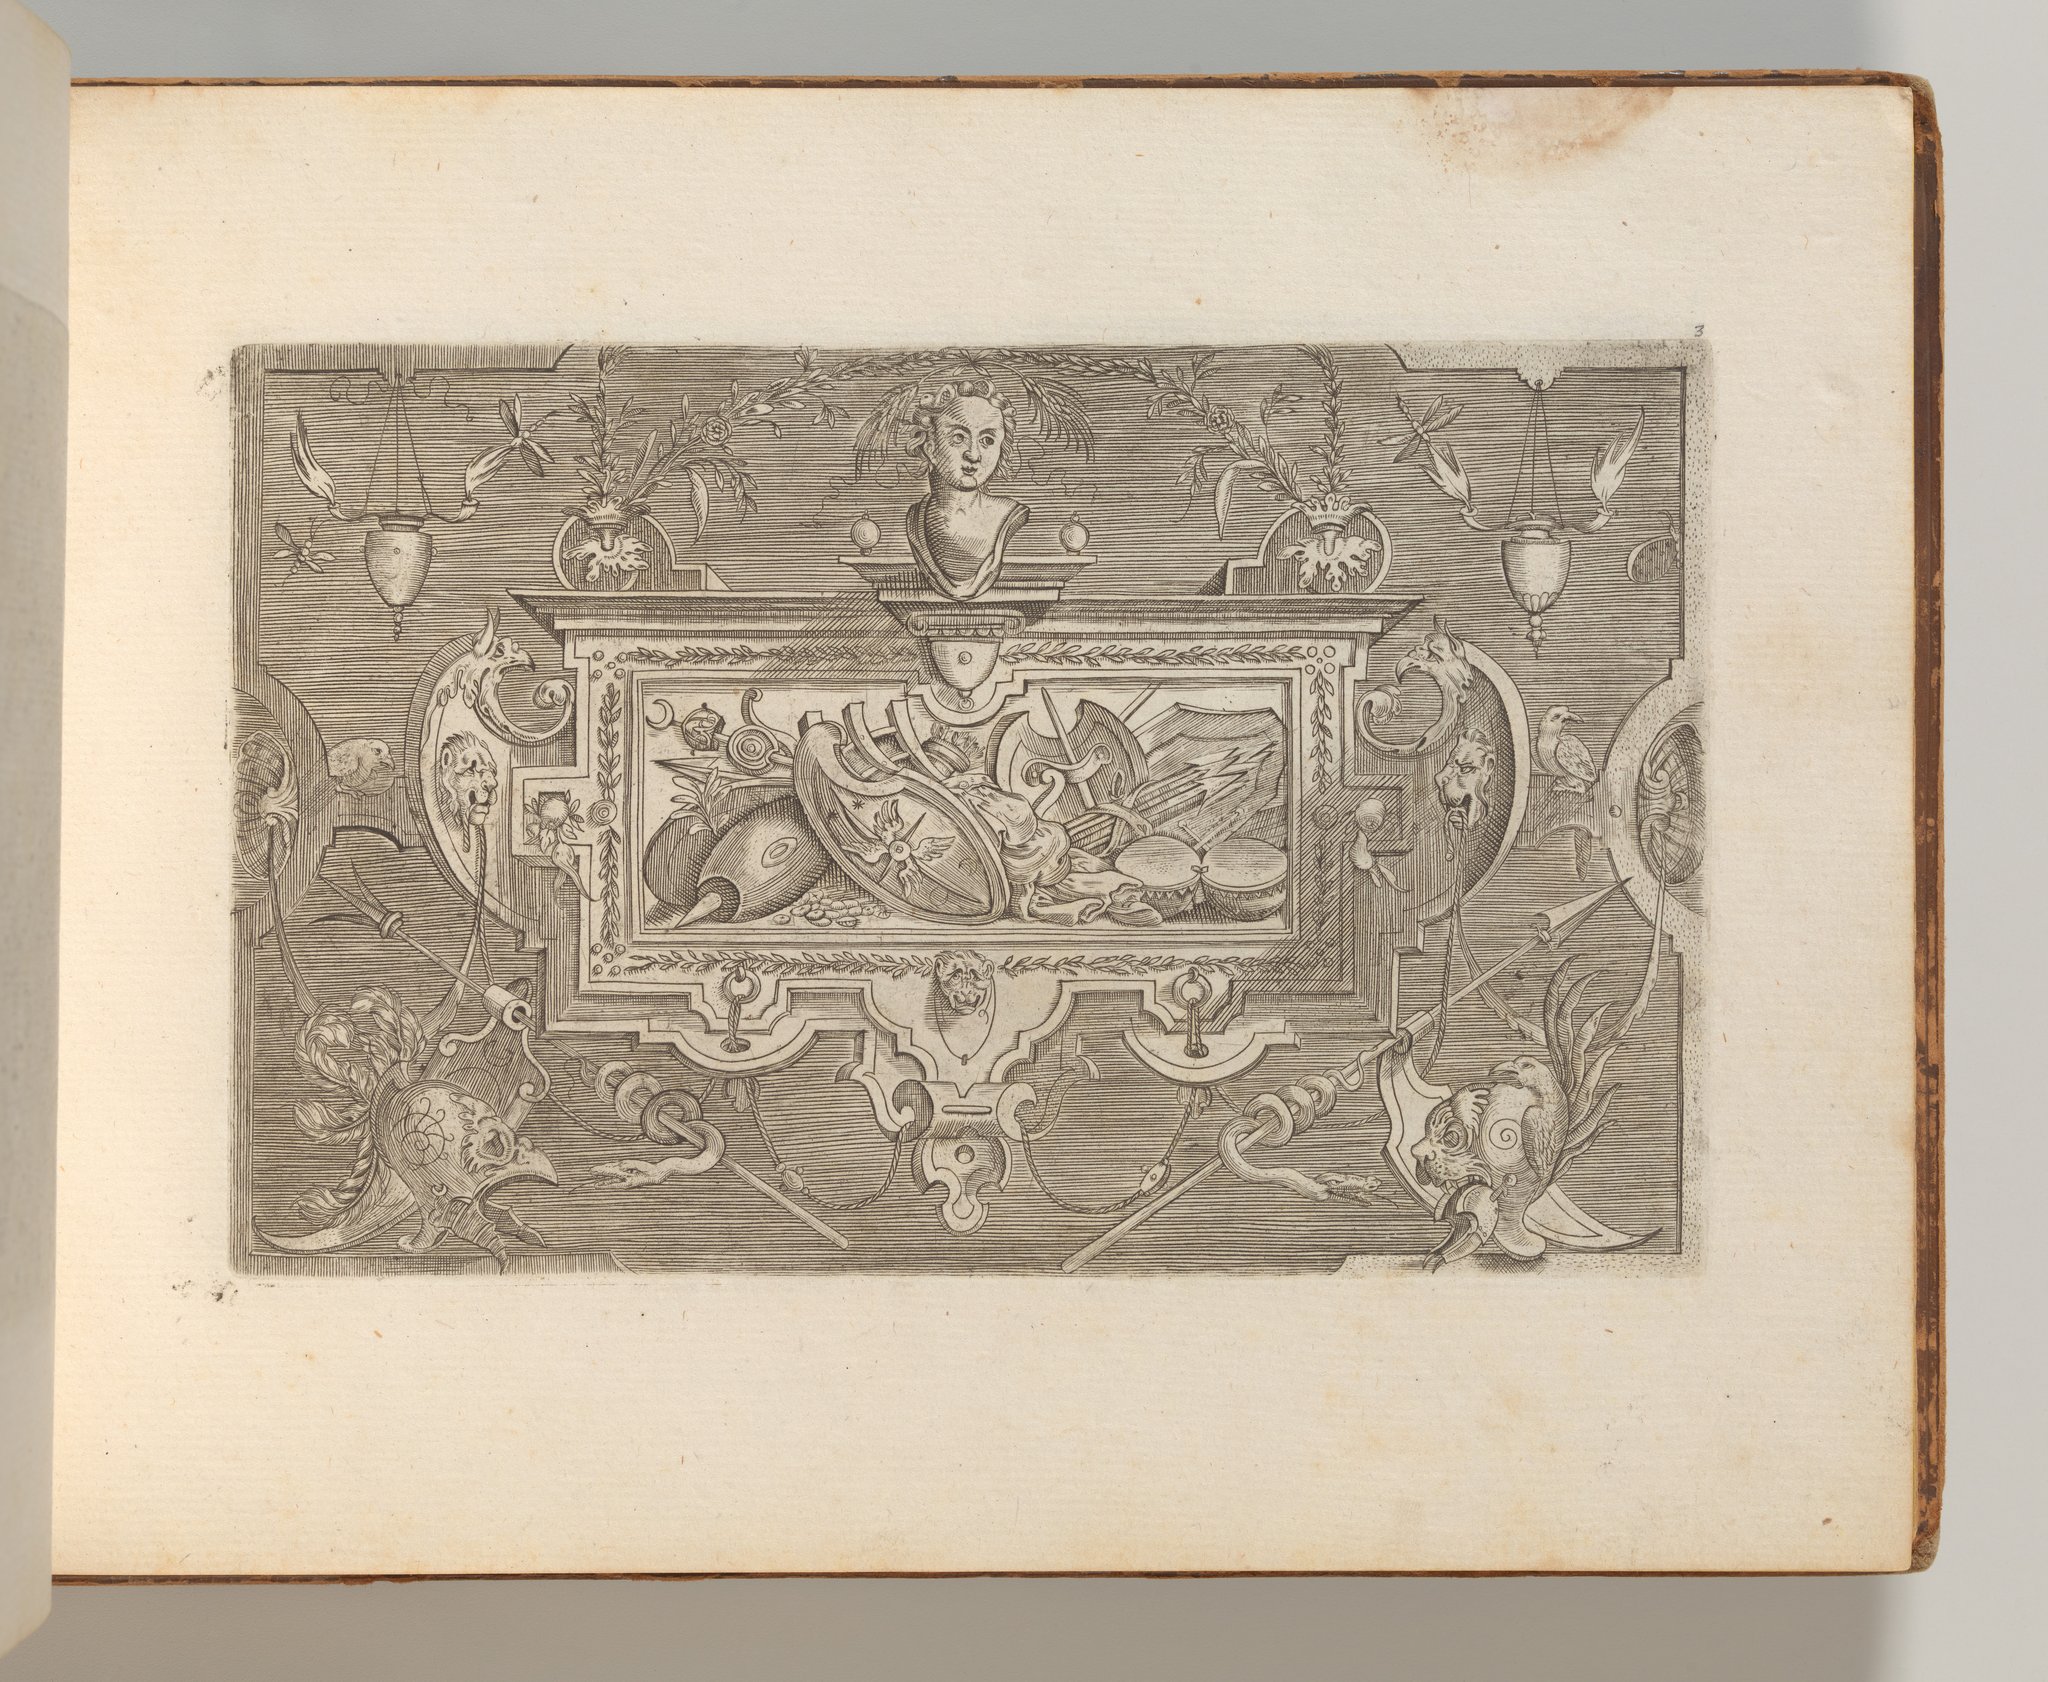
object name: album print ornament architecture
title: Targhe ed altri ornati di varie e capricciose invenzioni (Cartouches and other ornaments of various and capricious invention, page 3)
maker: jacob floris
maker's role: artist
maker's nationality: central european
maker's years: 1524-1581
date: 1773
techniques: engraving, etching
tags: birds,armor,women